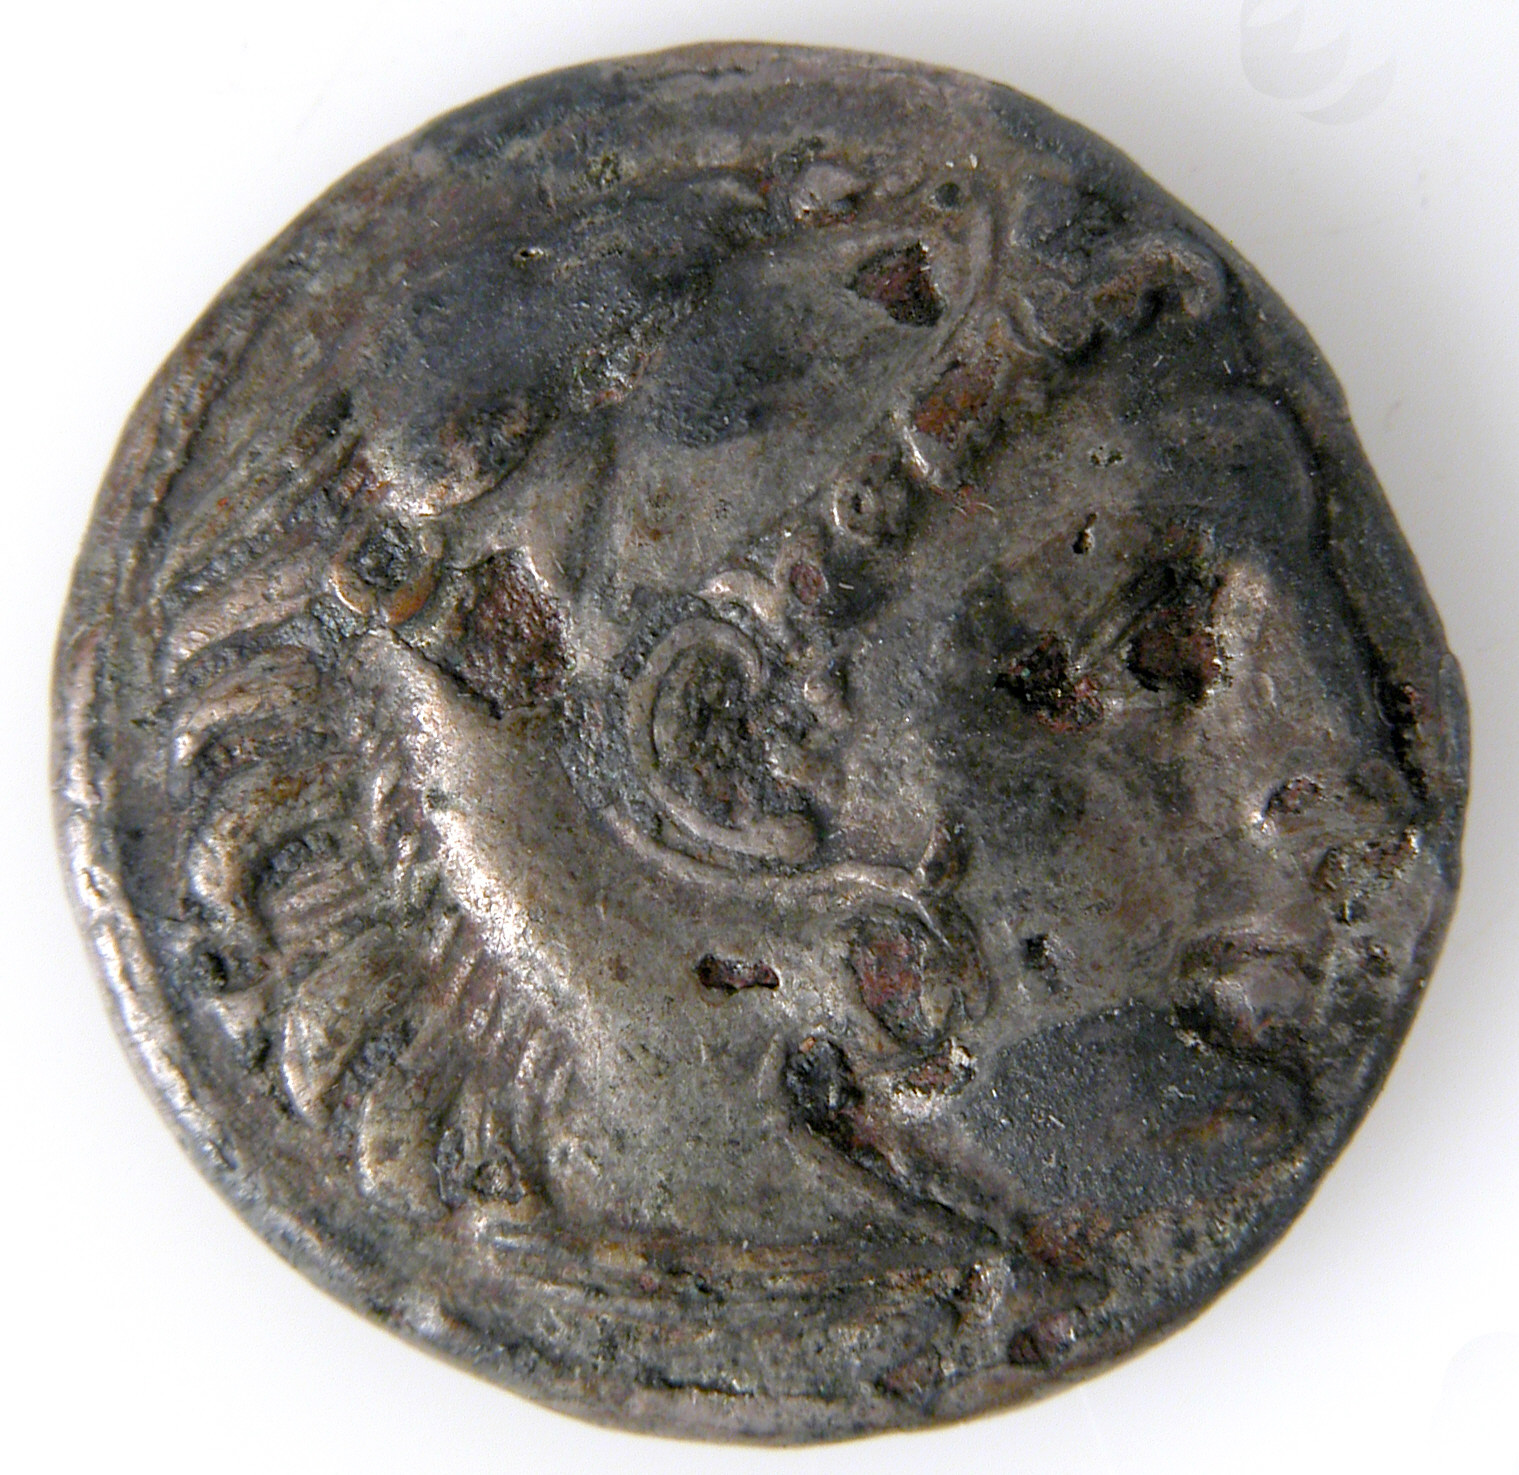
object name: coin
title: Drachm of Alexander the Great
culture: roman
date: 200-500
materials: silver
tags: alexander the great,profiles